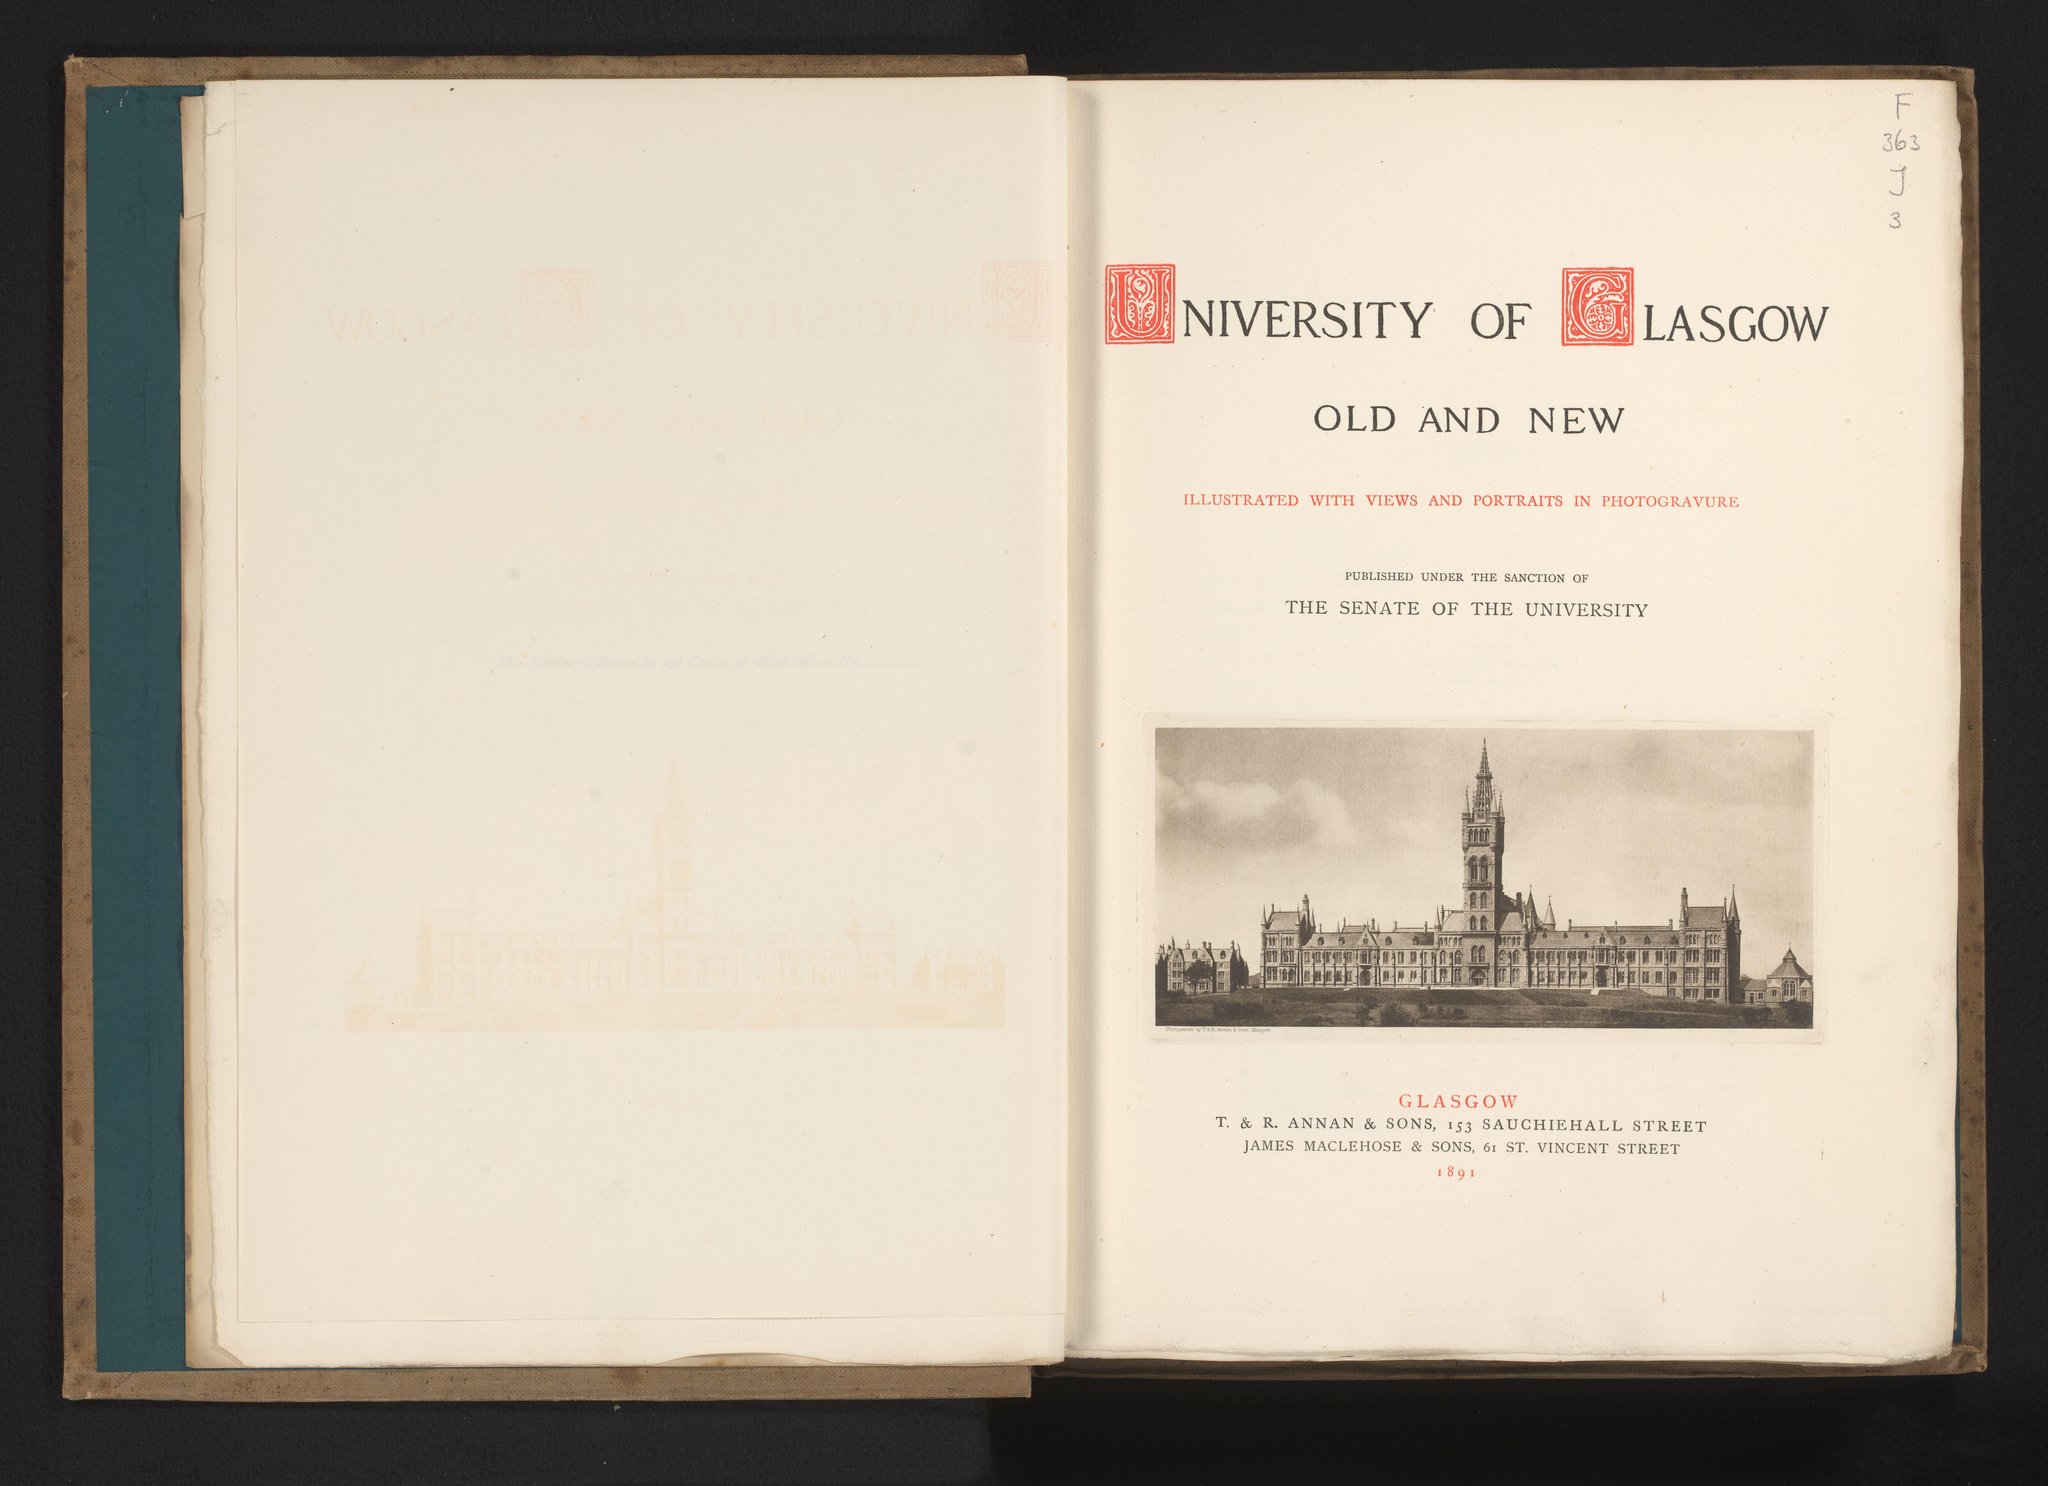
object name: page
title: Gezicht op het Gilbert Scottgebouw van de universiteit van Glasgow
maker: Anonymous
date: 1886-1891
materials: paper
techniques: photoaquatint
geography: glasgow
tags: university (+ building ~ education, tuition), glasgow